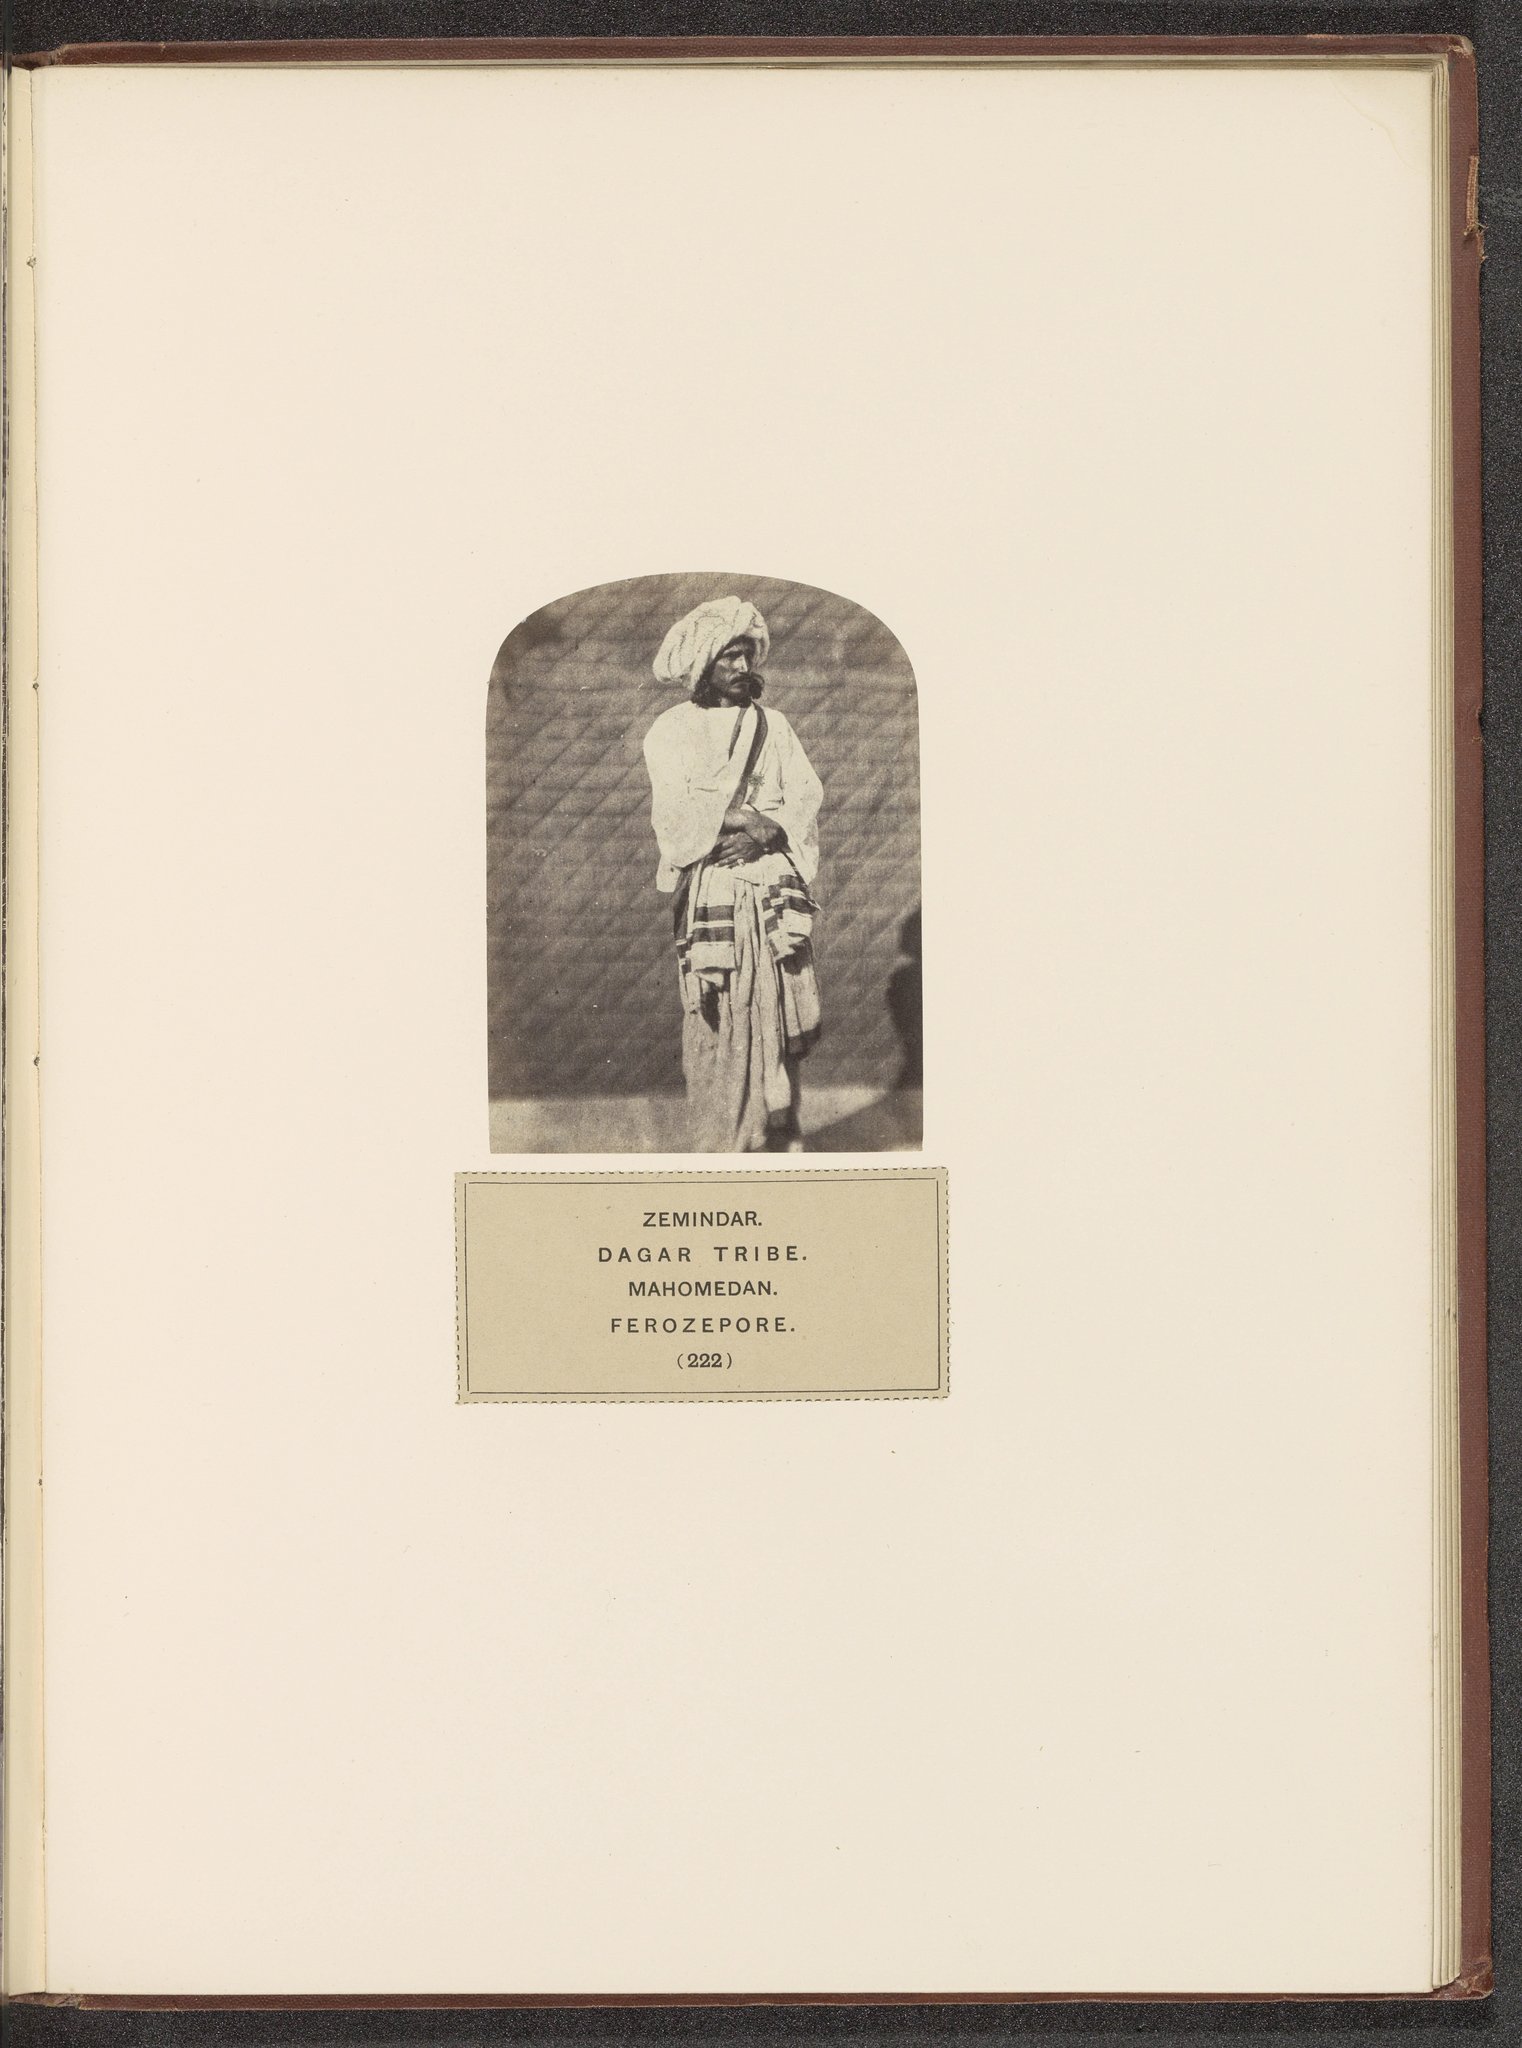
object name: photograph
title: Portrait of an unknown landowner from Firozpur, Punjab, India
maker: Anonymous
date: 1859-1869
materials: photographic support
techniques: albumen print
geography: firozpur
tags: head-gear: turban, human races; peoples; nationalities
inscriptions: inscription: ‘ZEMINDAR./ DAGAR TRIBE./ MAHOMEDAN./ FEROZEPORE.’, number: ‘(222)’